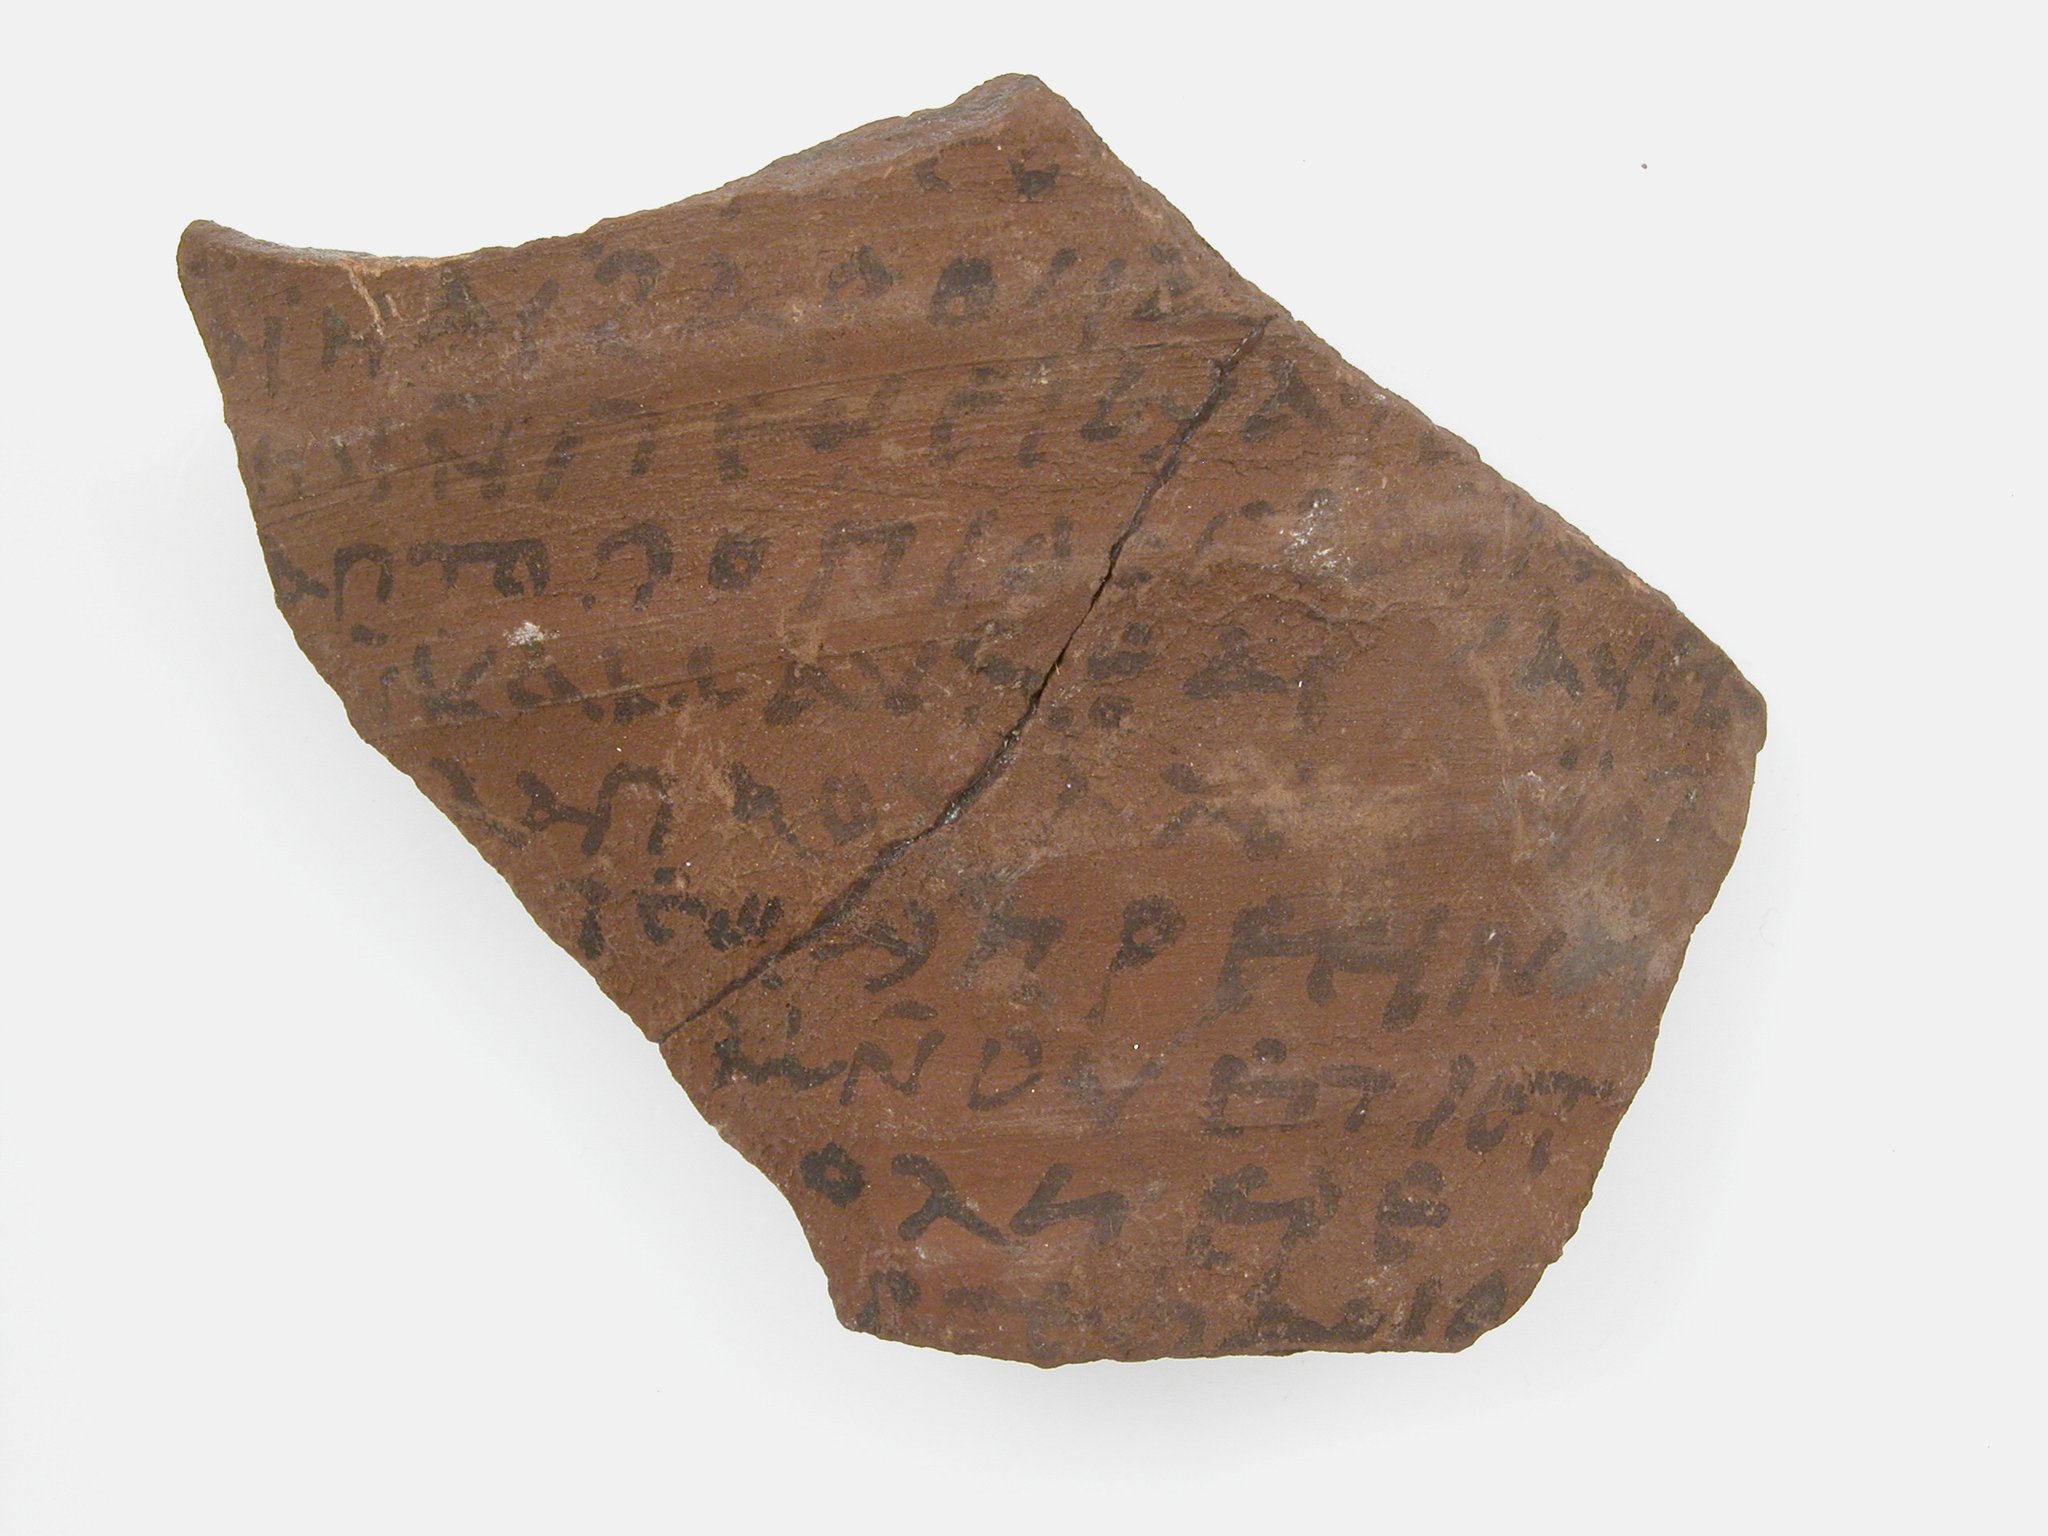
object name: ostrakon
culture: coptic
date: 601-700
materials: ink, pottery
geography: egypt